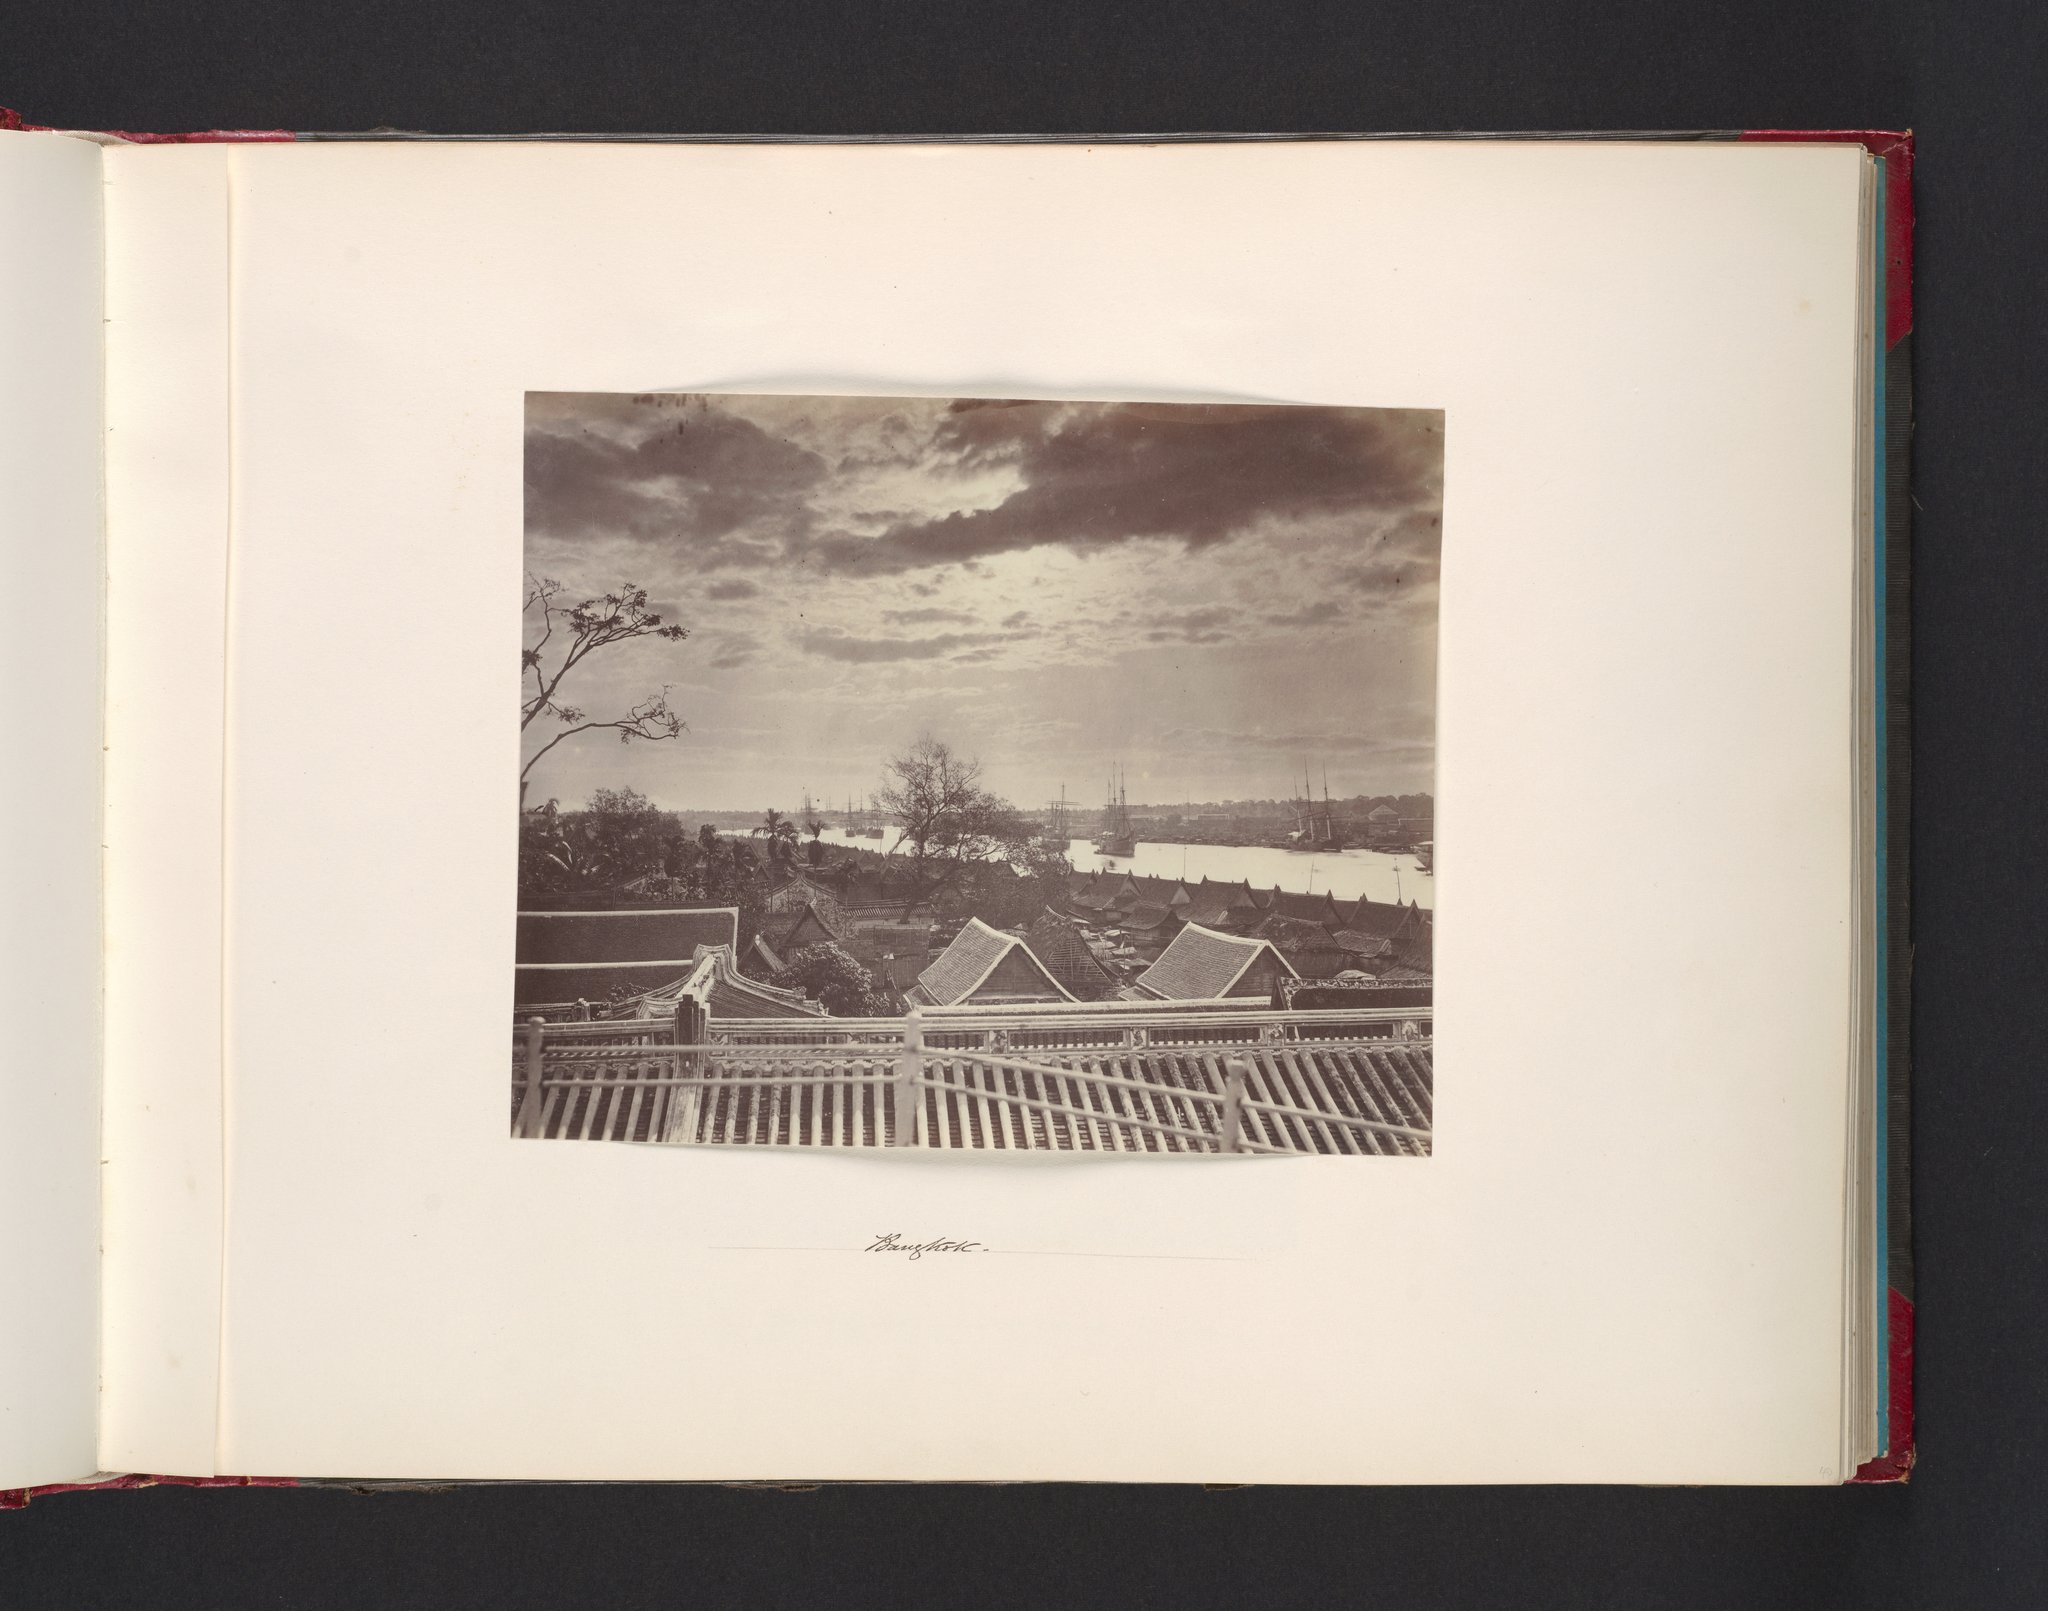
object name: photograph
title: Bangkok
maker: john thomson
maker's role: artist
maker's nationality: british, scottish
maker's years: 1837-1921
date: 1865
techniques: albumen silver print, glass negative